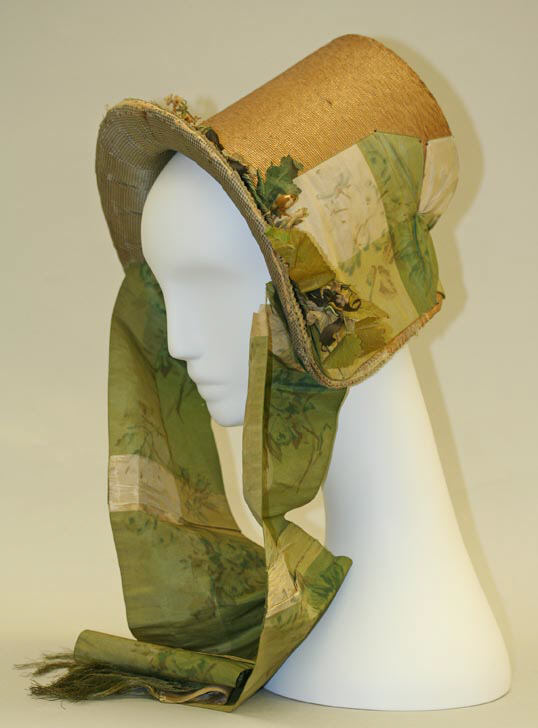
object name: bonnet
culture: american or european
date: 1840-1849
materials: fiber